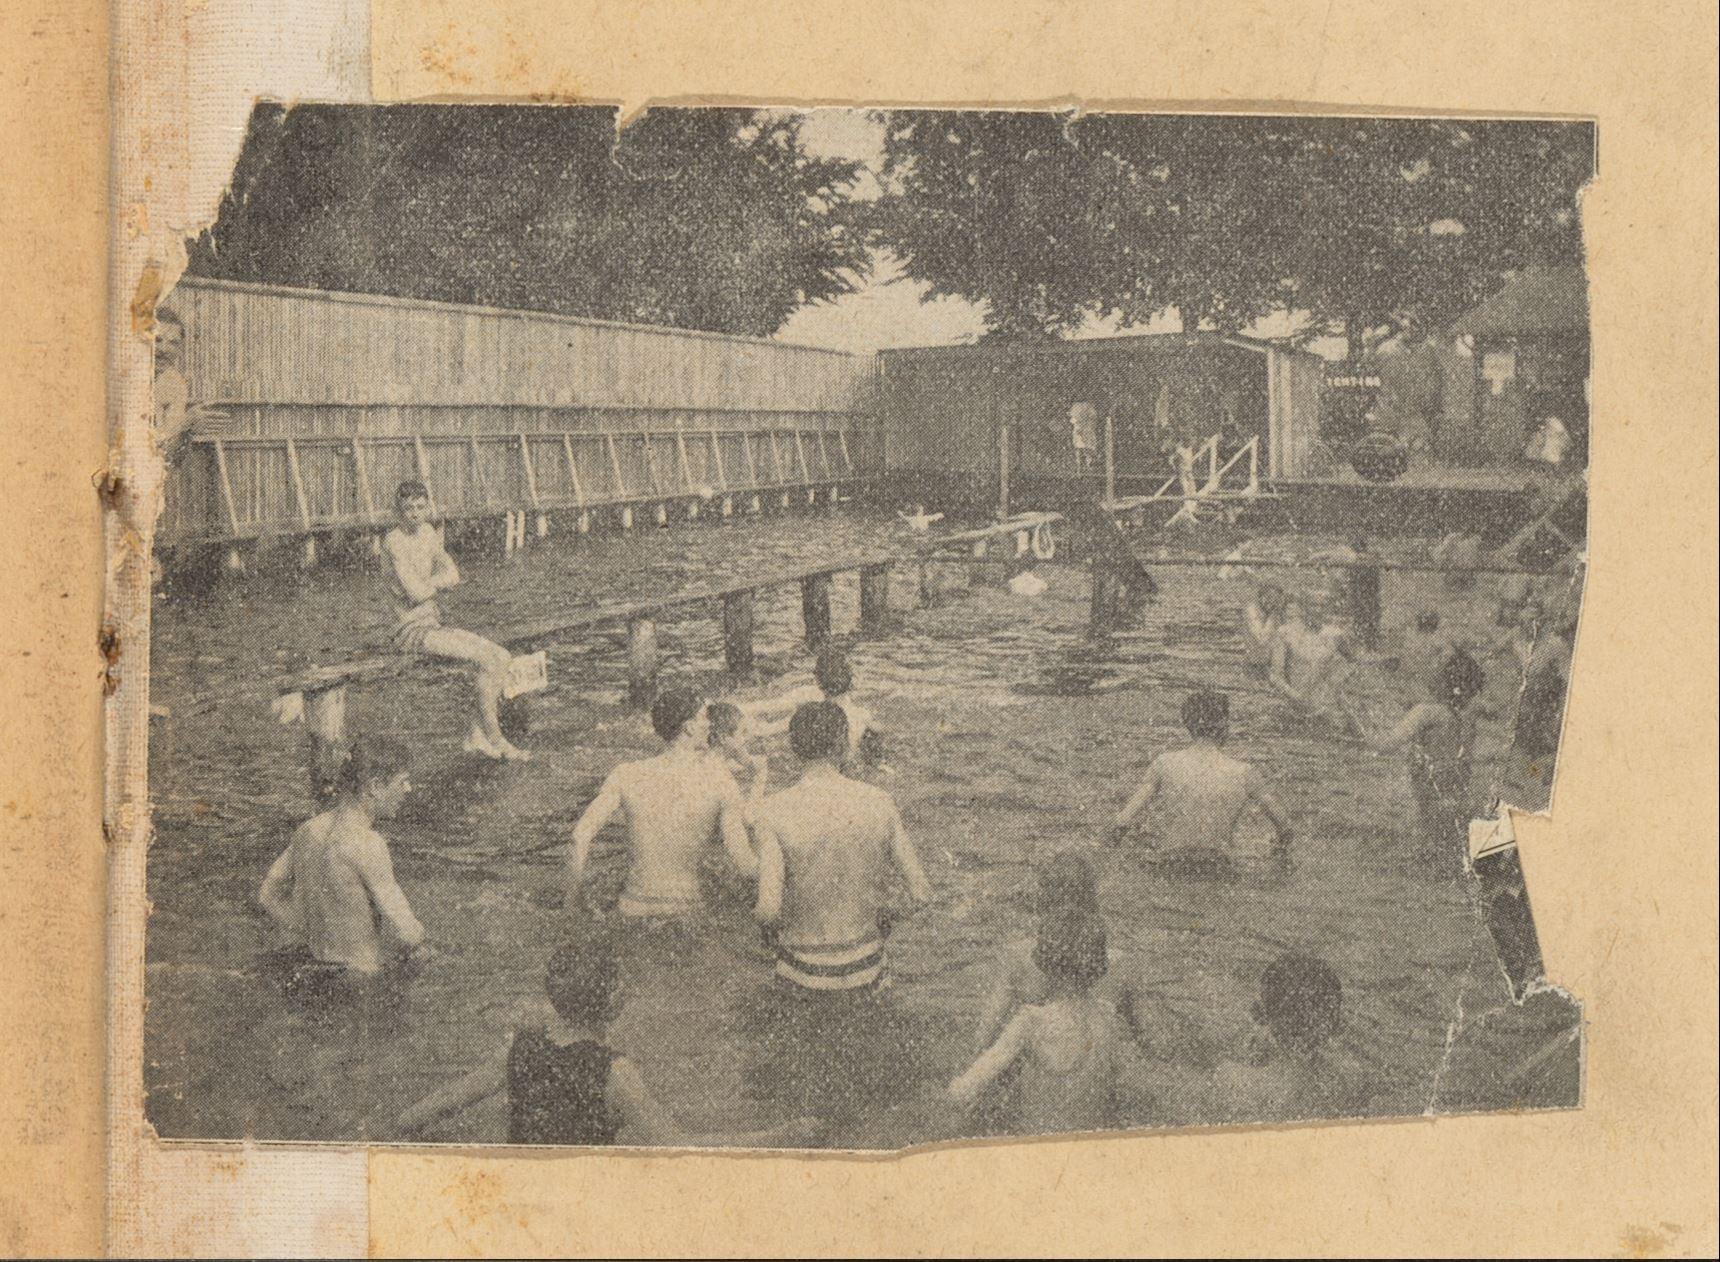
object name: photograph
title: Mensen in een zwembad, vermoedelijk in Nederland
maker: Anonymous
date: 1900-1920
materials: photographic support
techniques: offset printed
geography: netherlands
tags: pond, pool, netherlands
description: Onderdeel van Familiealbum met foto's van een familie in de voormalige kolonie Nederlands-Indië en van een suikerfabriek in Purworejo.